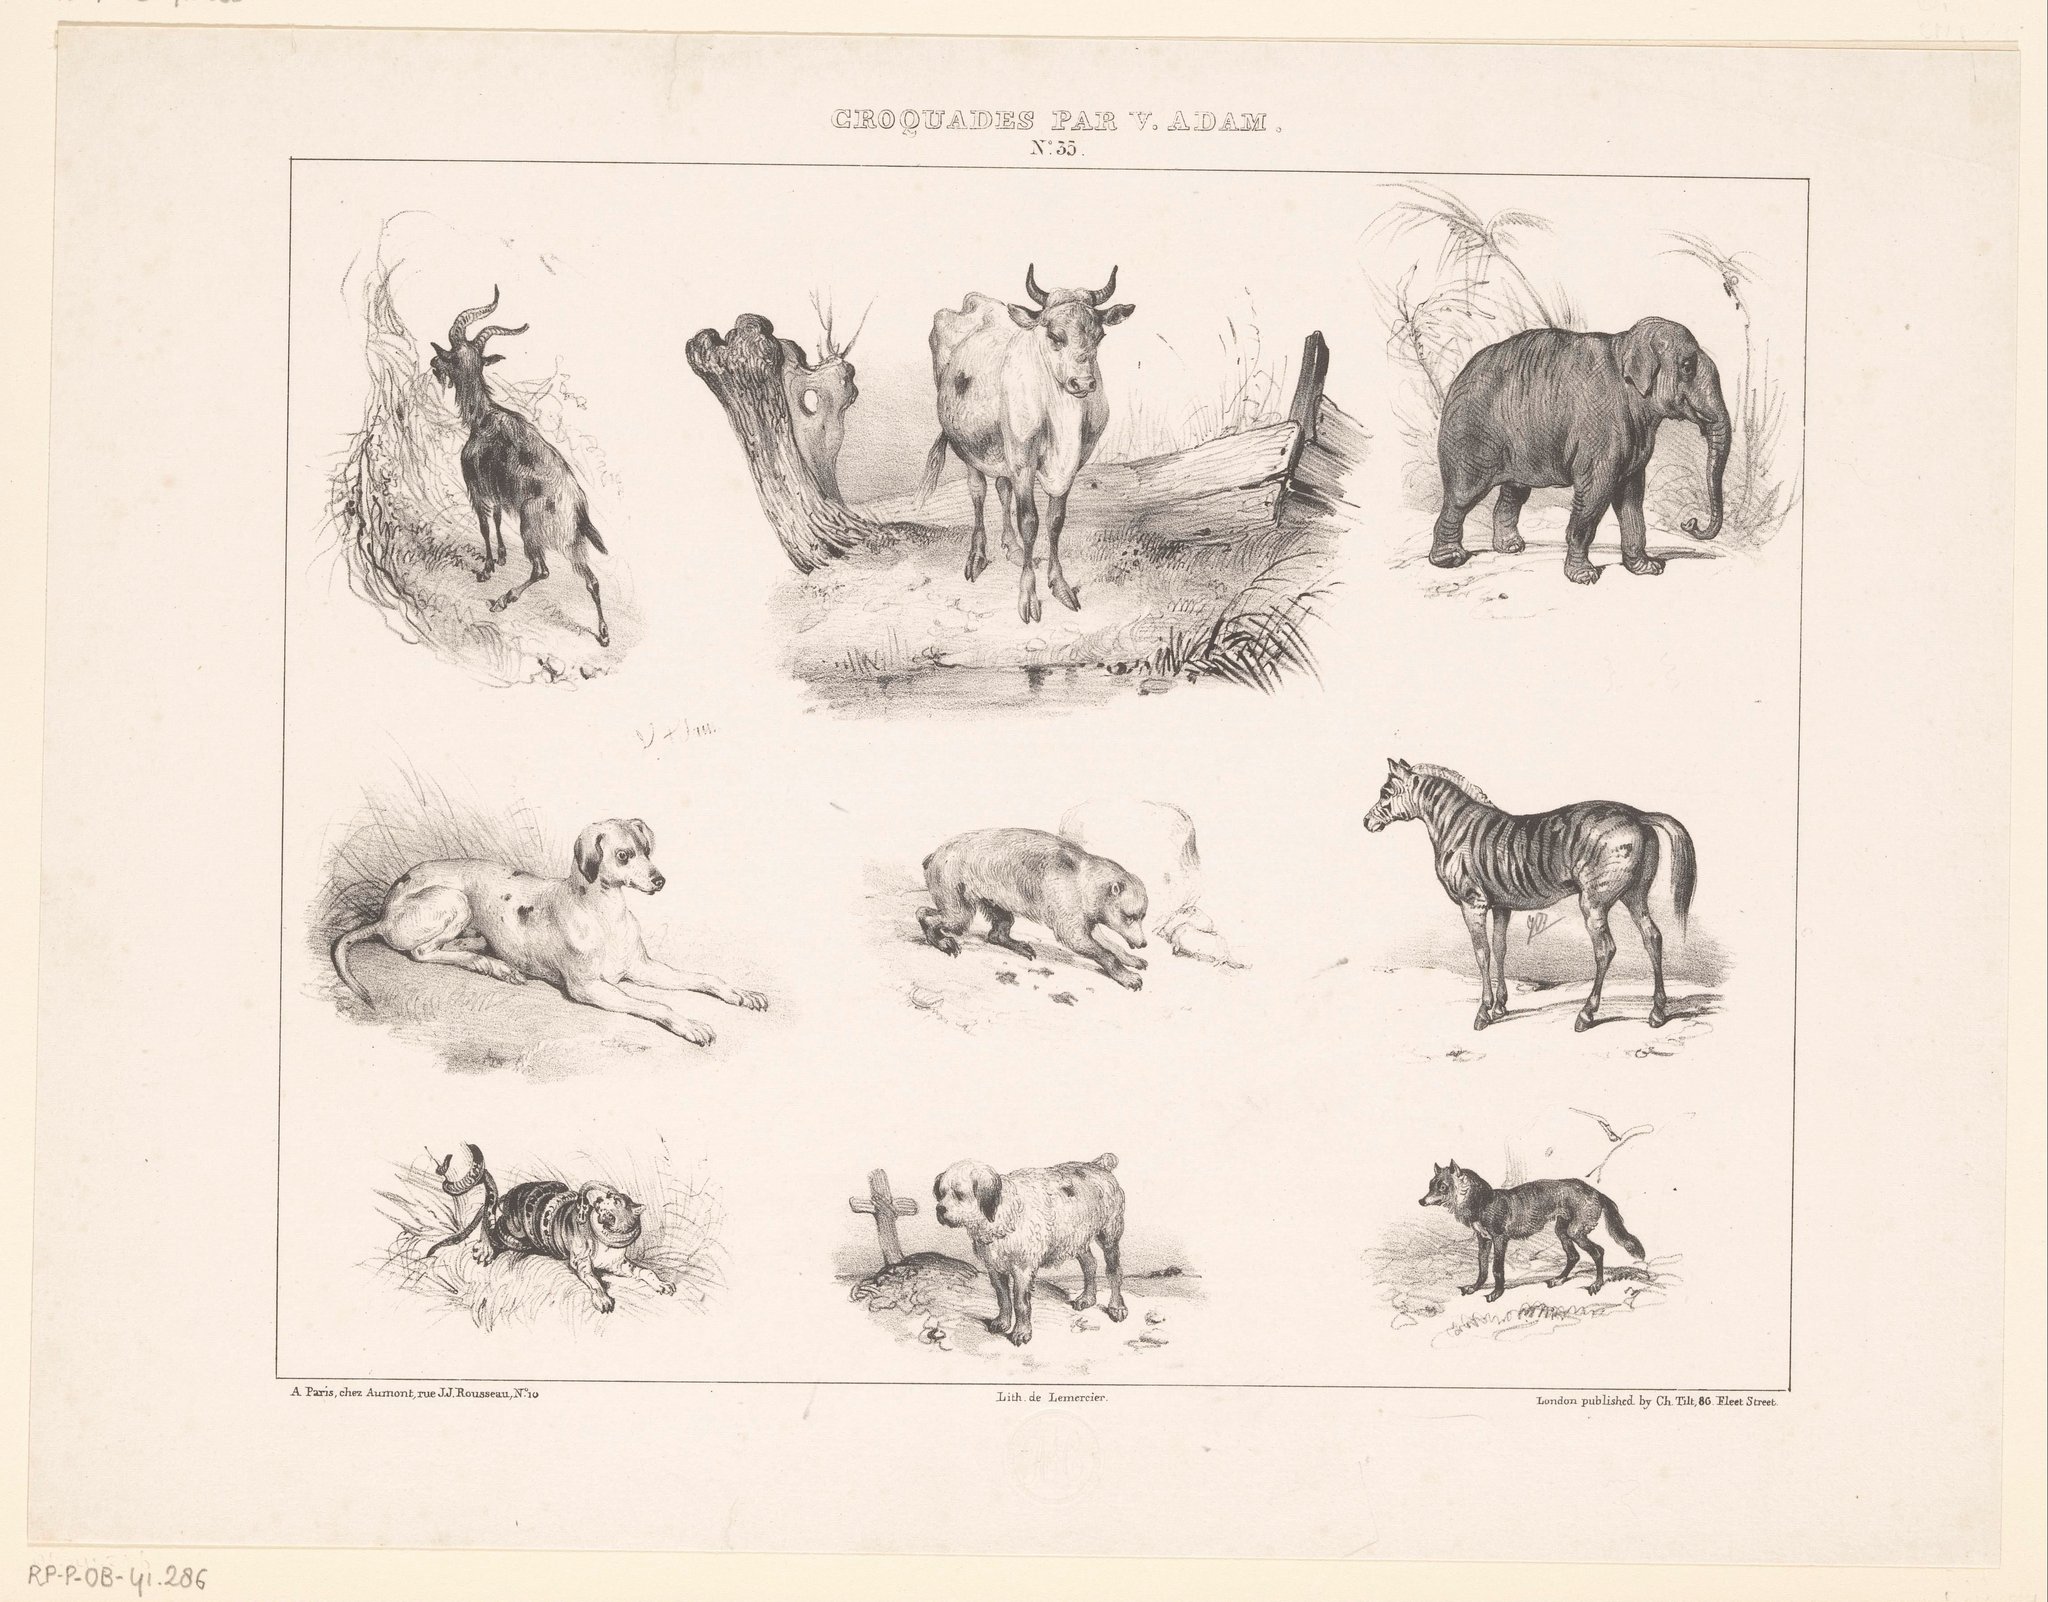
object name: print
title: Croquades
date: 1833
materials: paper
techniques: lithograph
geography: paris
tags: snakes, hoofed animals (with name), cow, beasts of prey, predatory animals: bear, goat, trunked animals: elephant, dog, beasts of prey, predatory animals: wolf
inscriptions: check stamp: Lugt 88b